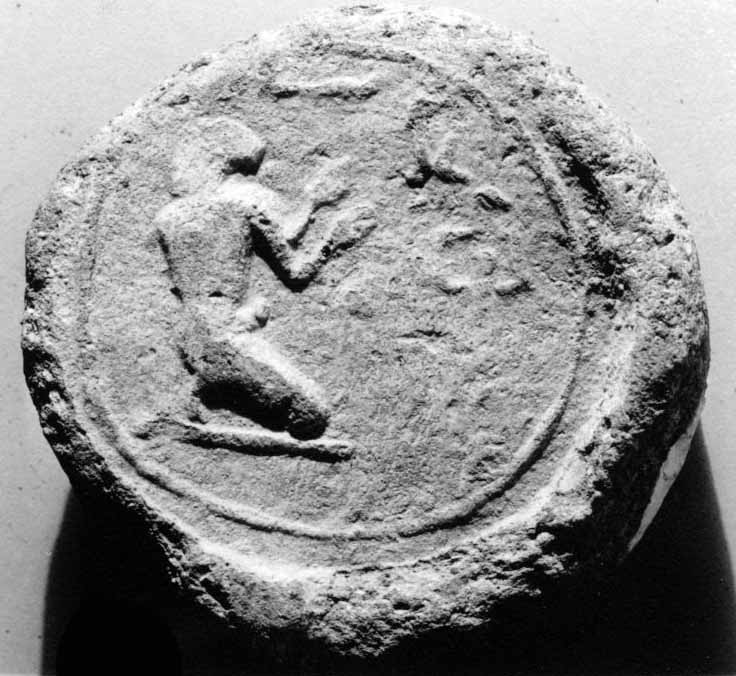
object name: cone, mahu, circular impression, guardian, treasury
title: Funerary Cone of the Guardian of the Treasury Mahu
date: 1550-1295 BCE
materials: pottery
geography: egypt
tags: men